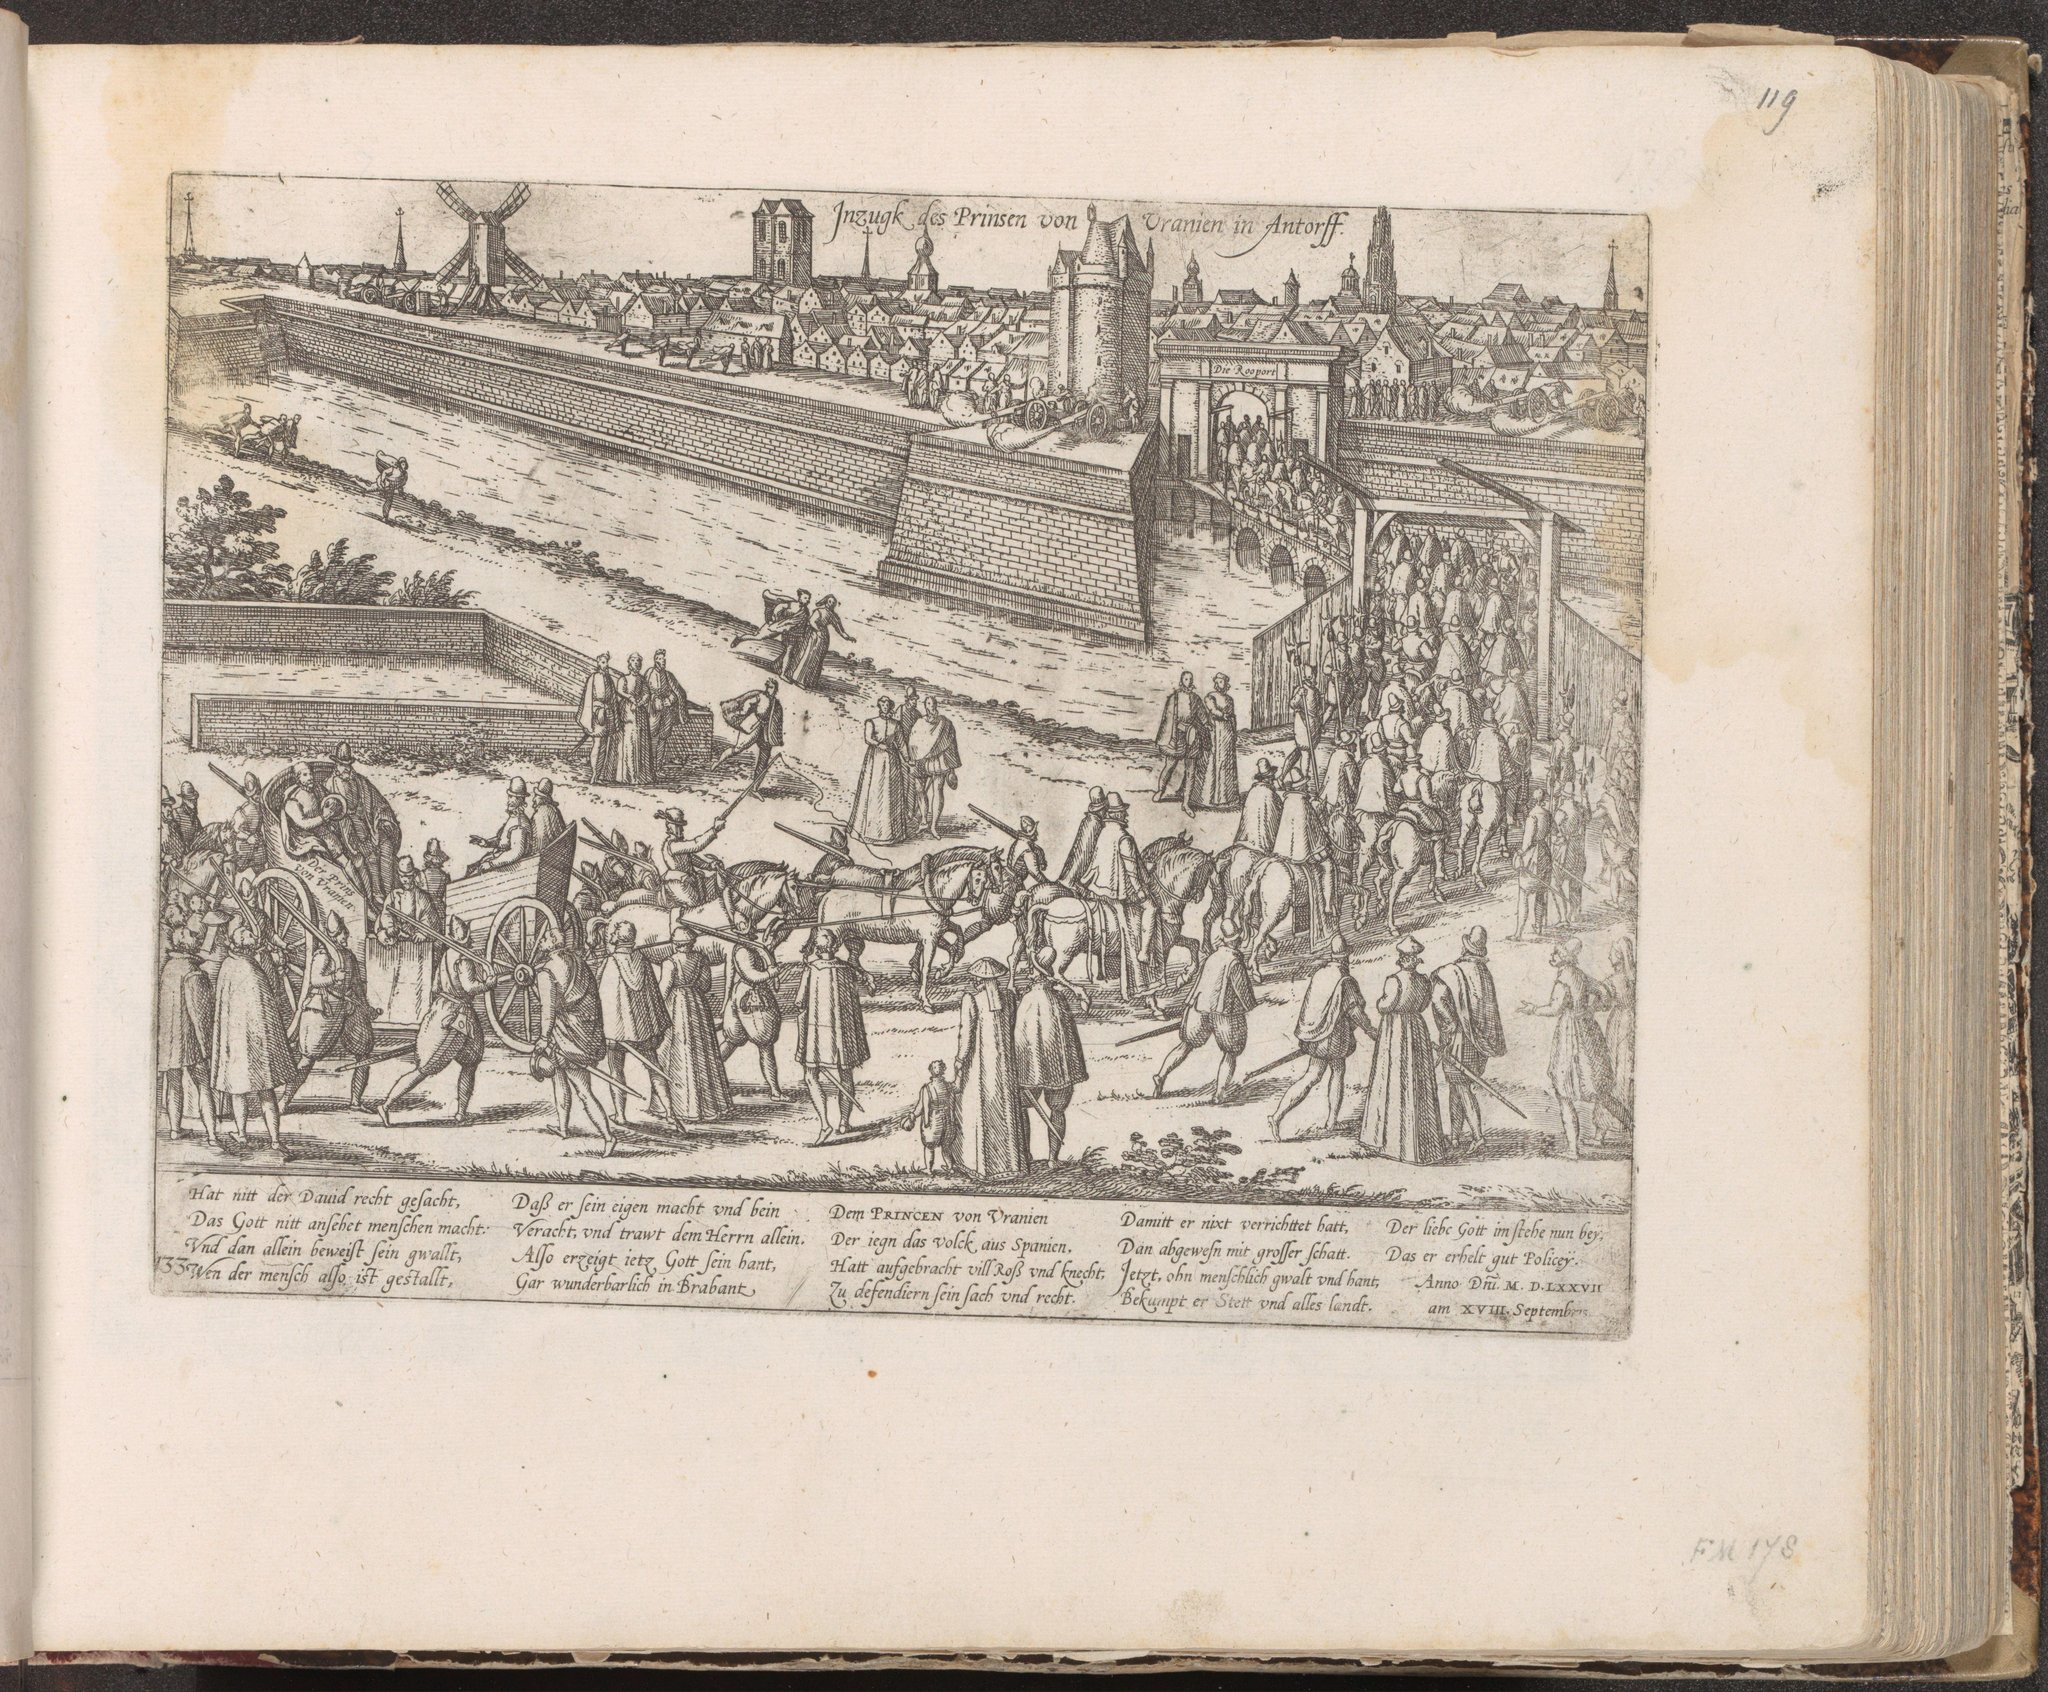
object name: album leaf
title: Inzugk des Prinsen von Uranien in Antorff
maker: frans hogenberg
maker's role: print maker, publisher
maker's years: 1538-1590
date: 1581-1585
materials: paper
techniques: etching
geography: cologne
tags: delft, william i (prince of orange), triumphal entry and public reception, pageant, 'entrée solennelle', 'joyeuse entrée'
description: Intocht van de prins van Oranje te Antwerpen, 18 september 1577. Stoet met de prins van Oranje in een open wagen trekt door de Roopoort / Rodepoort de stad binnen. Met onderschrift van 18 regels in het Duits. Linksonder genummerd: 133. De prent maakt deel uit van een album.